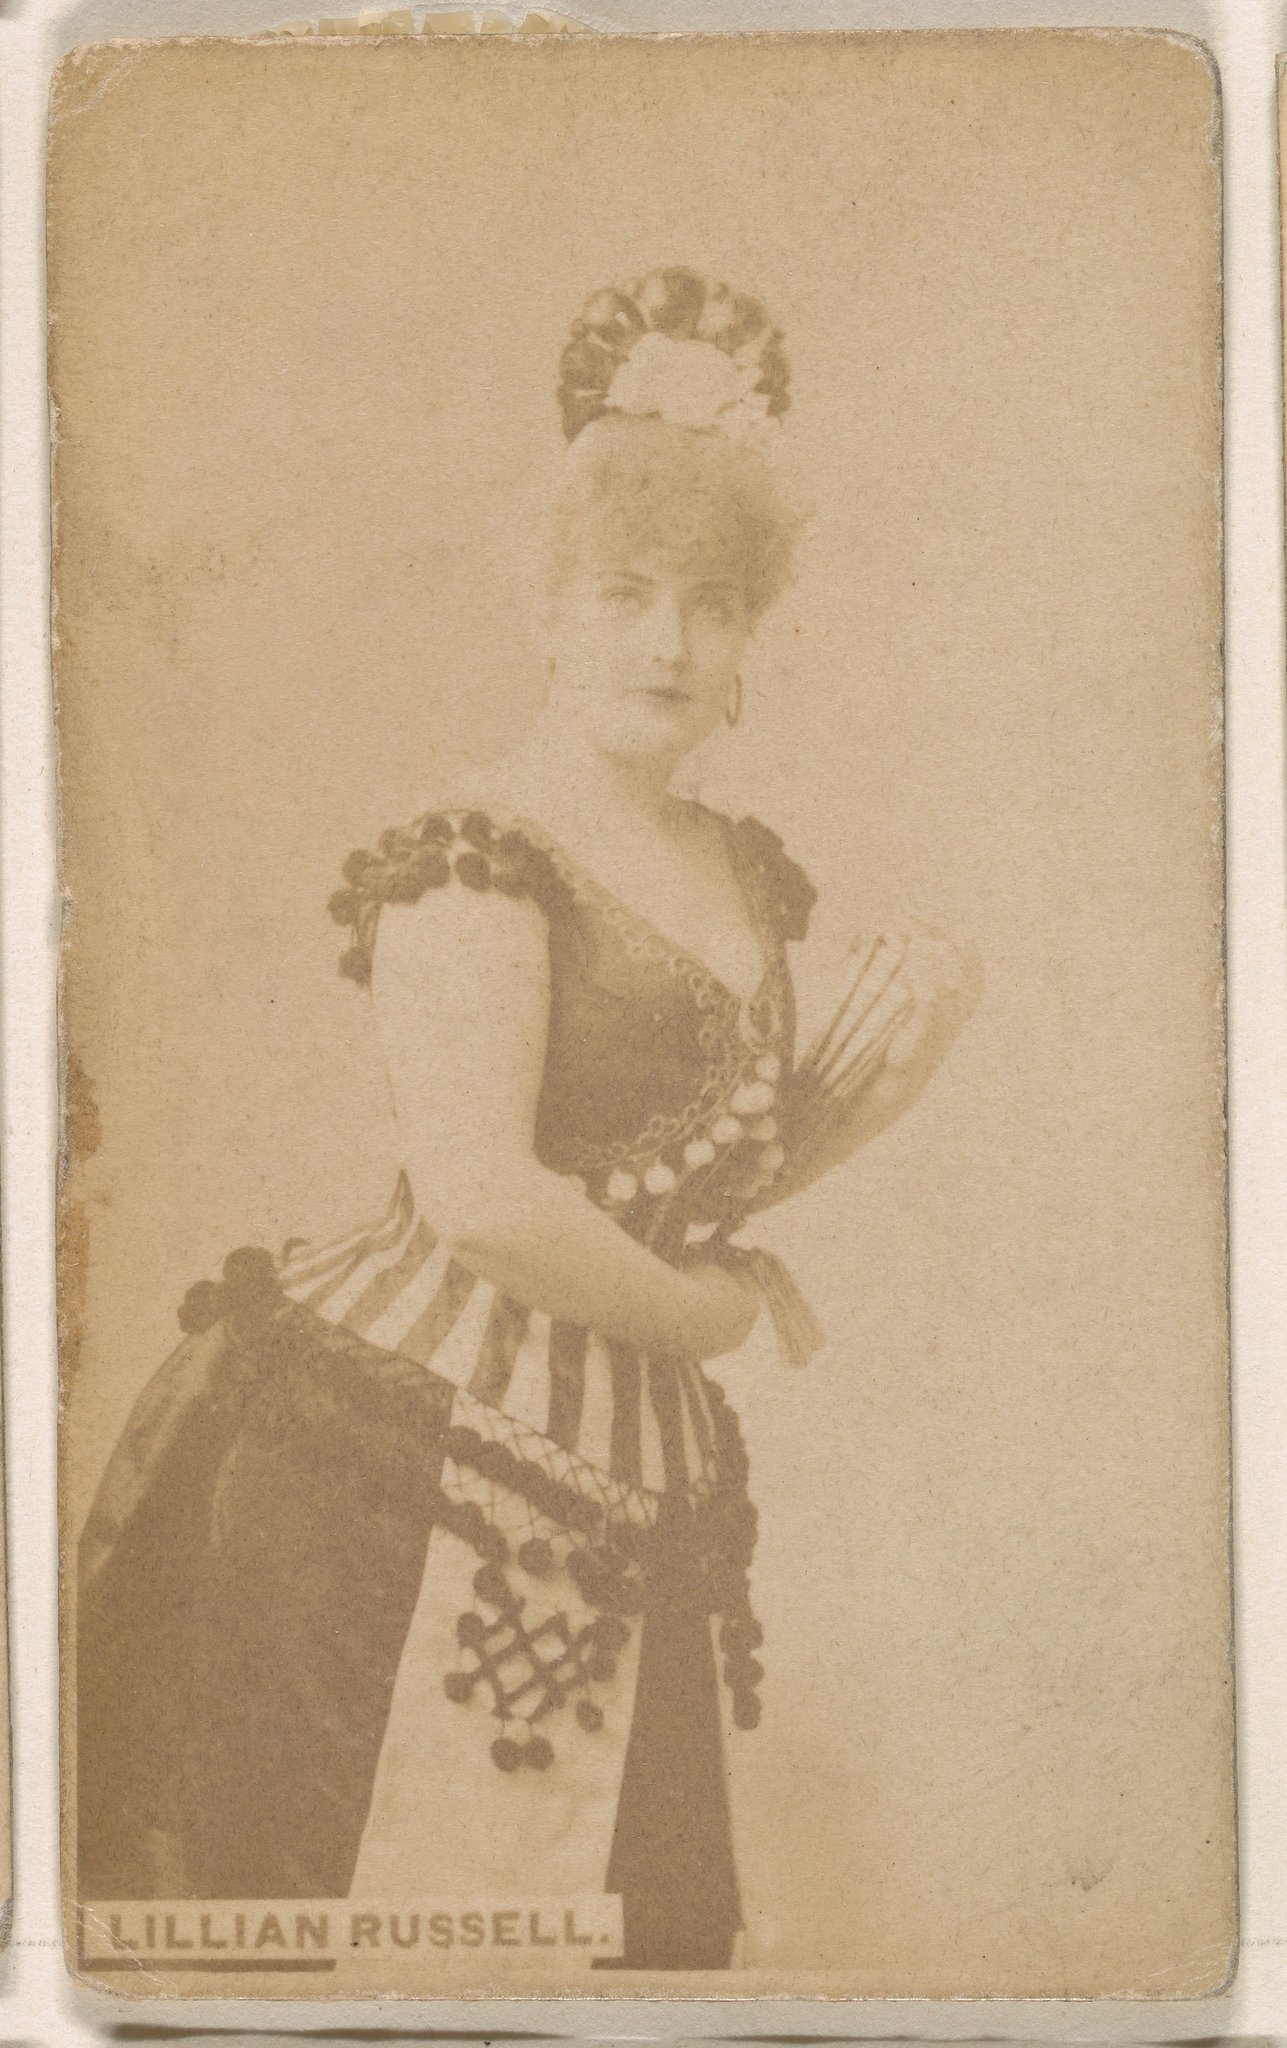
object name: photograph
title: Lillian Russell, from the Actresses series (N246), Type 1, issued by Kinney Brothers to promote Sporting Extra Cigarettes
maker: kinney brothers tobacco company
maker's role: publisher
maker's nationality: american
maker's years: 1869-2011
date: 1890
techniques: albumen silver print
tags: portraits,women,actresses